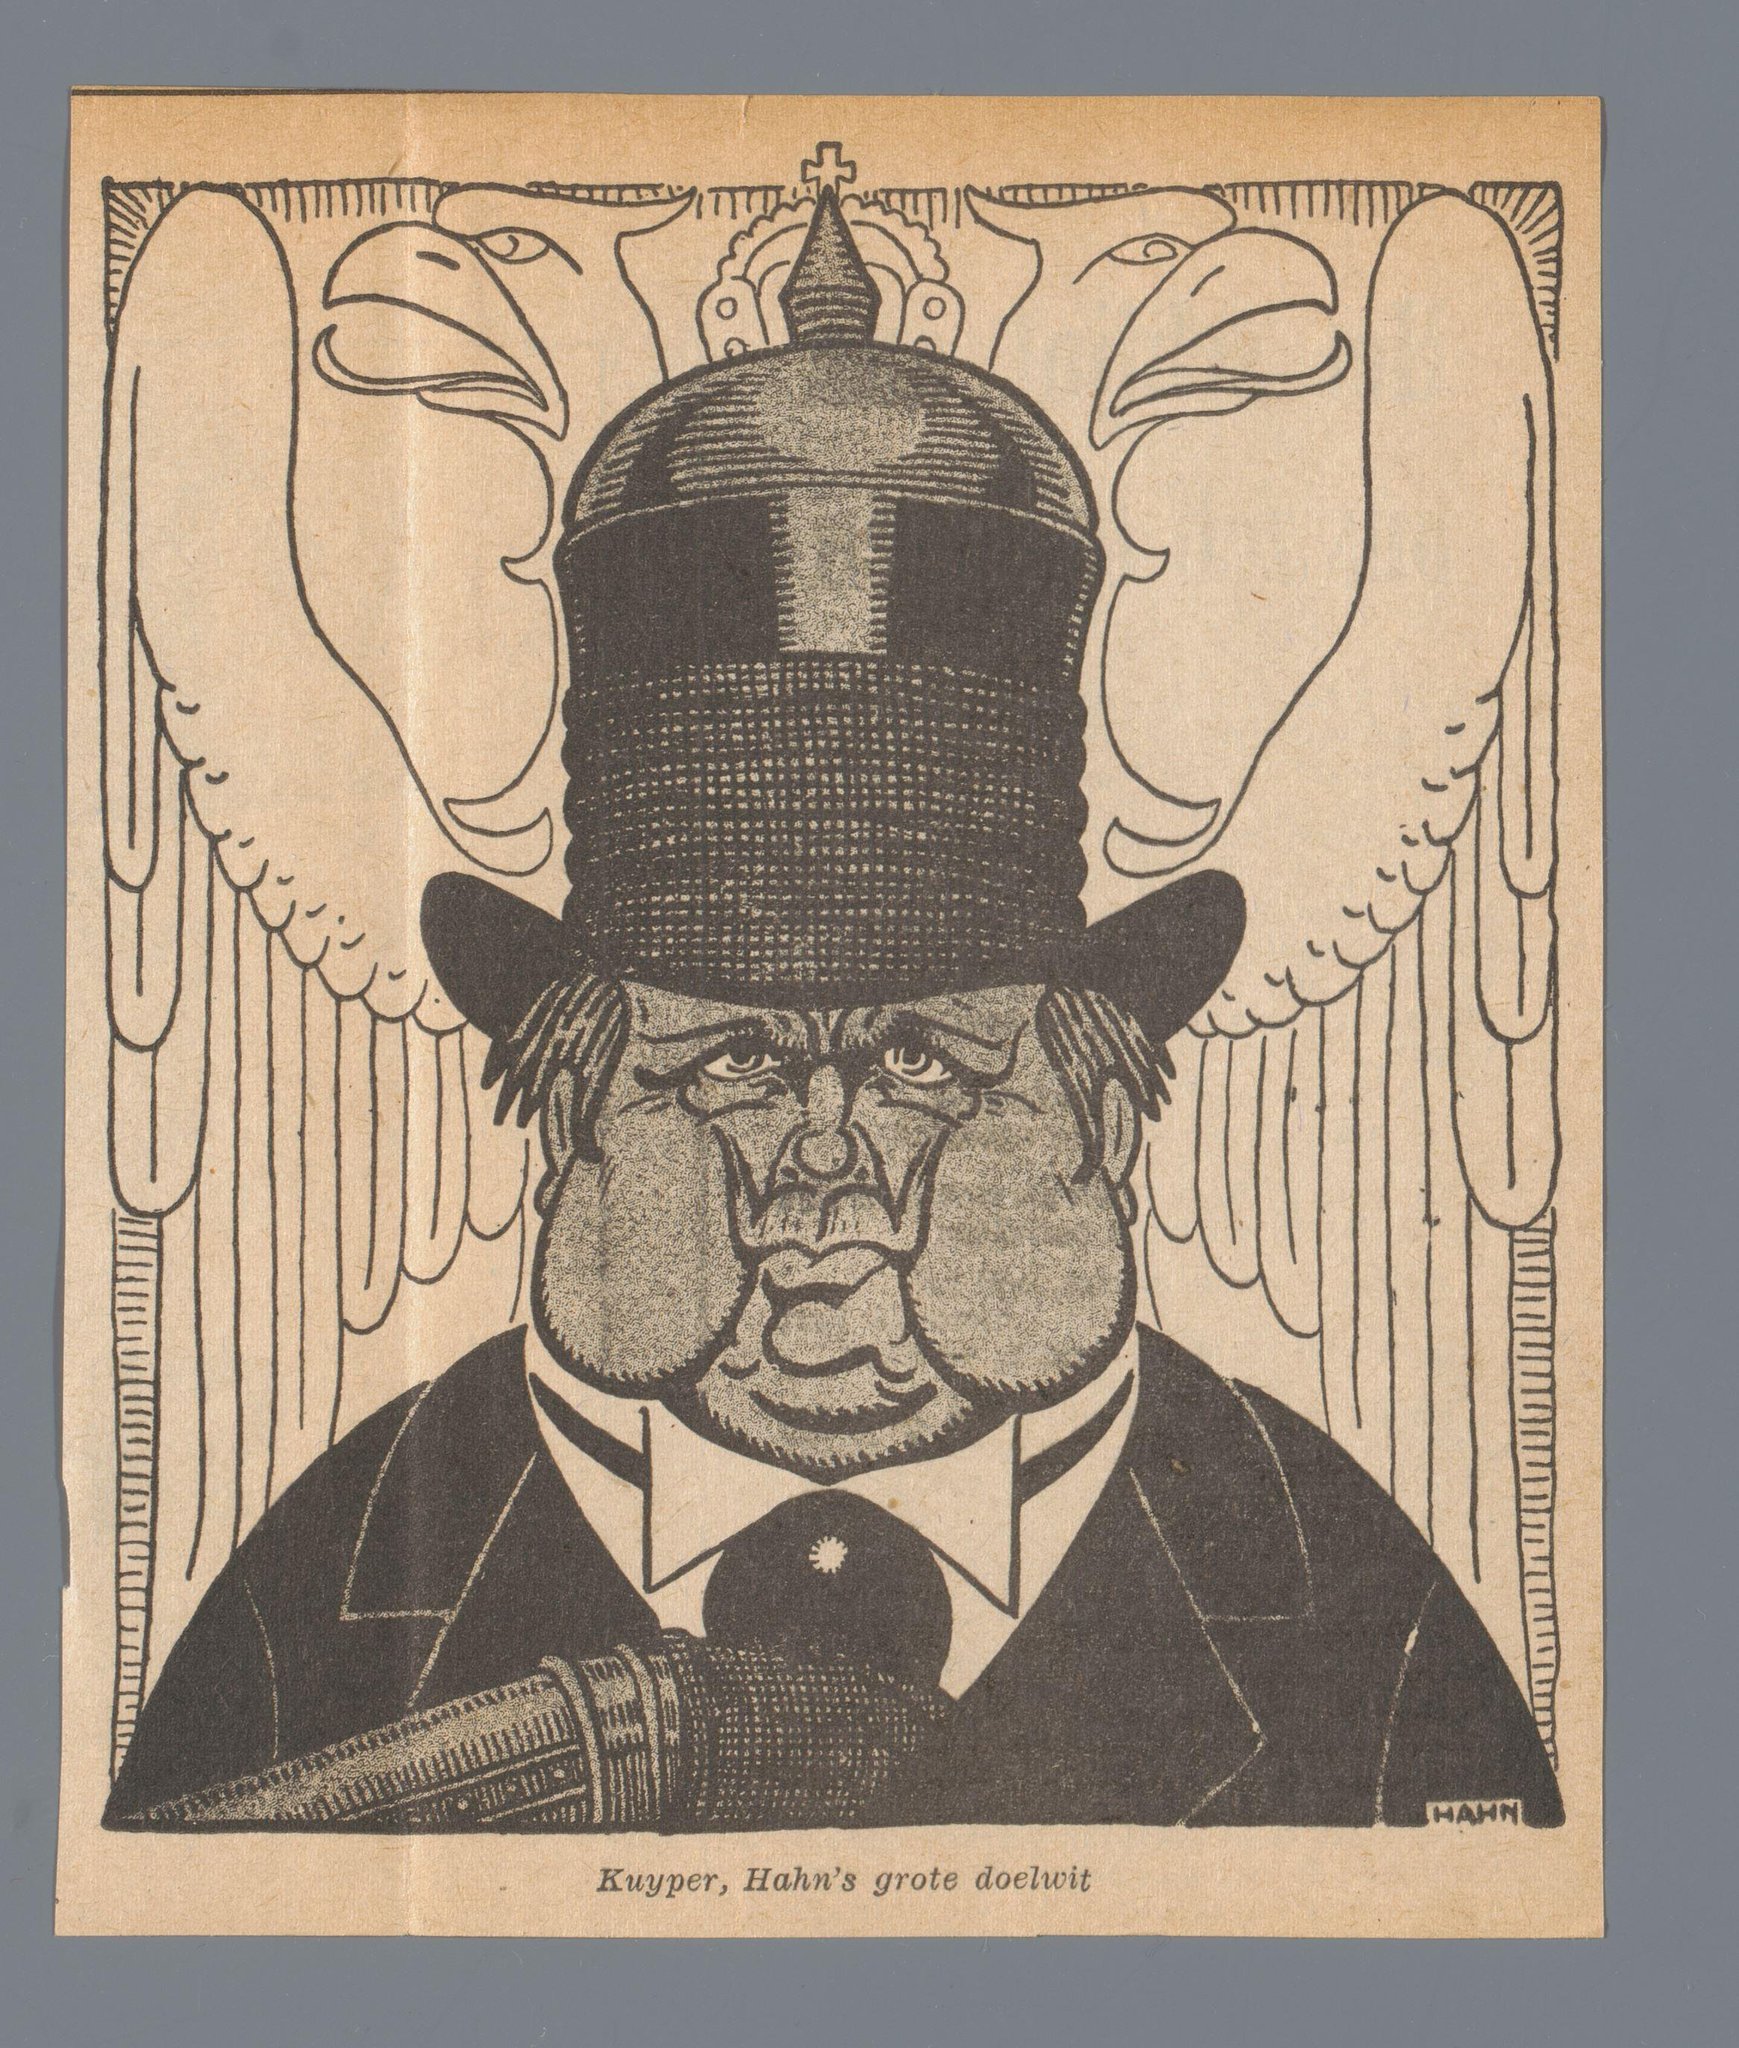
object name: newspaper clipping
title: Kuyper, Hahn's grote doelwit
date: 1903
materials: ink, paper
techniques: printing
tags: the hague, abraham kuyper, netherlands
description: Krantenknipsel met een spotprent van Dr. Abraham Kuyper getekend door Albert Hahn. Signatuur l.o.. Onder opschrift.